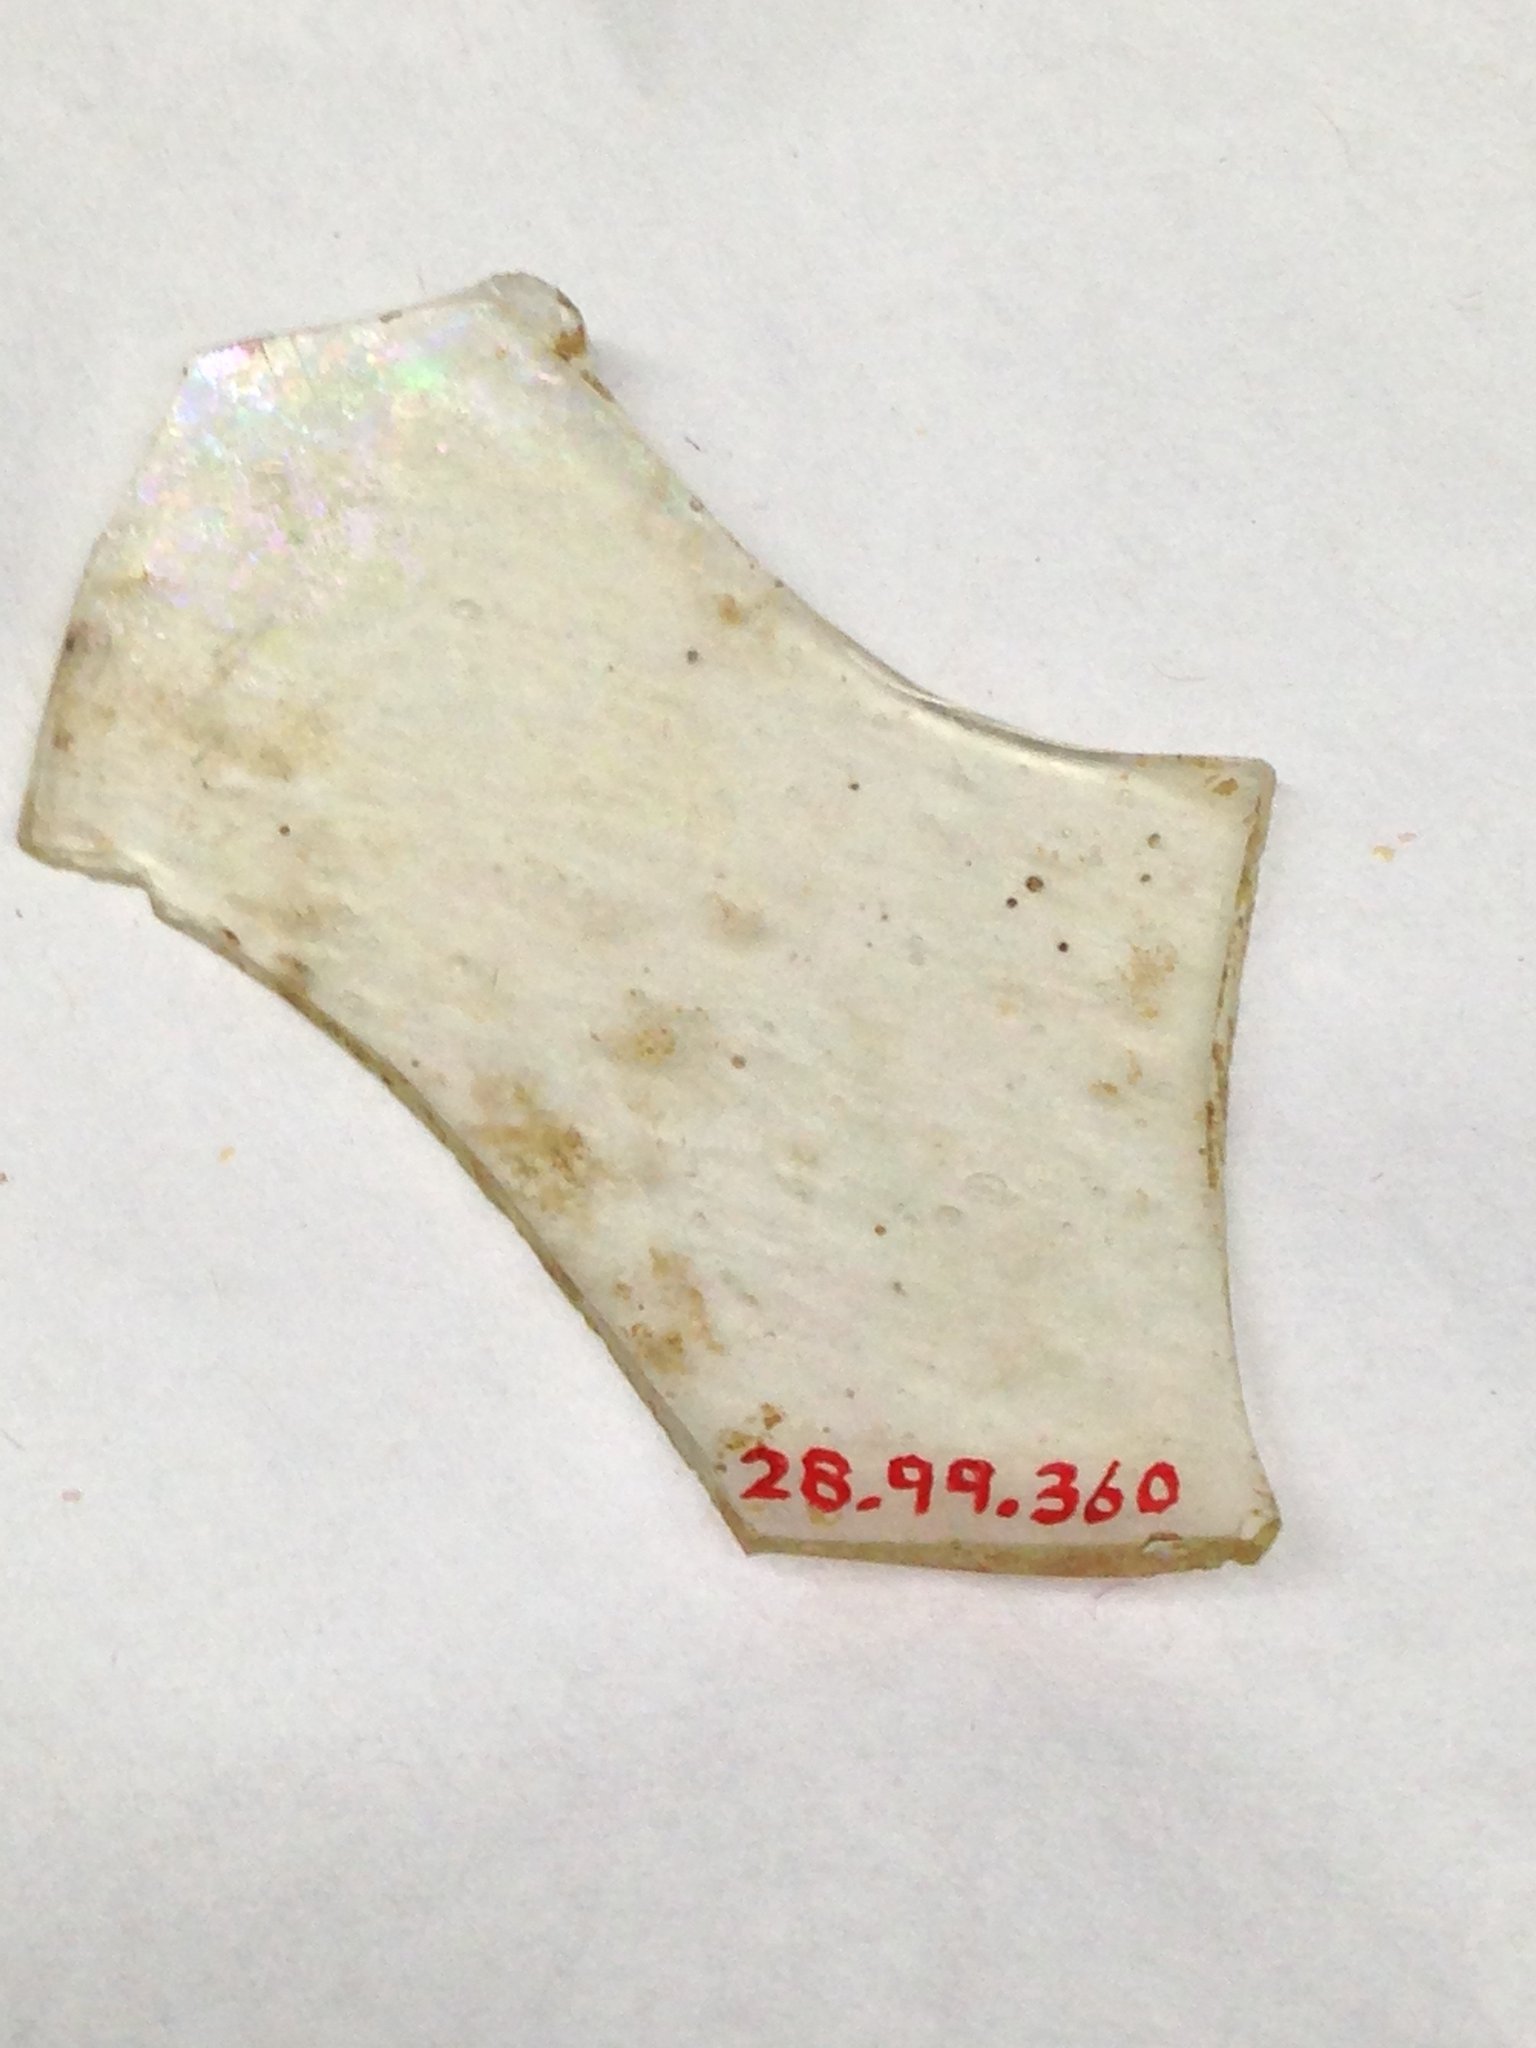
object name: fragment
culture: european or middle eastern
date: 1150-1250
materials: ceramic, glass